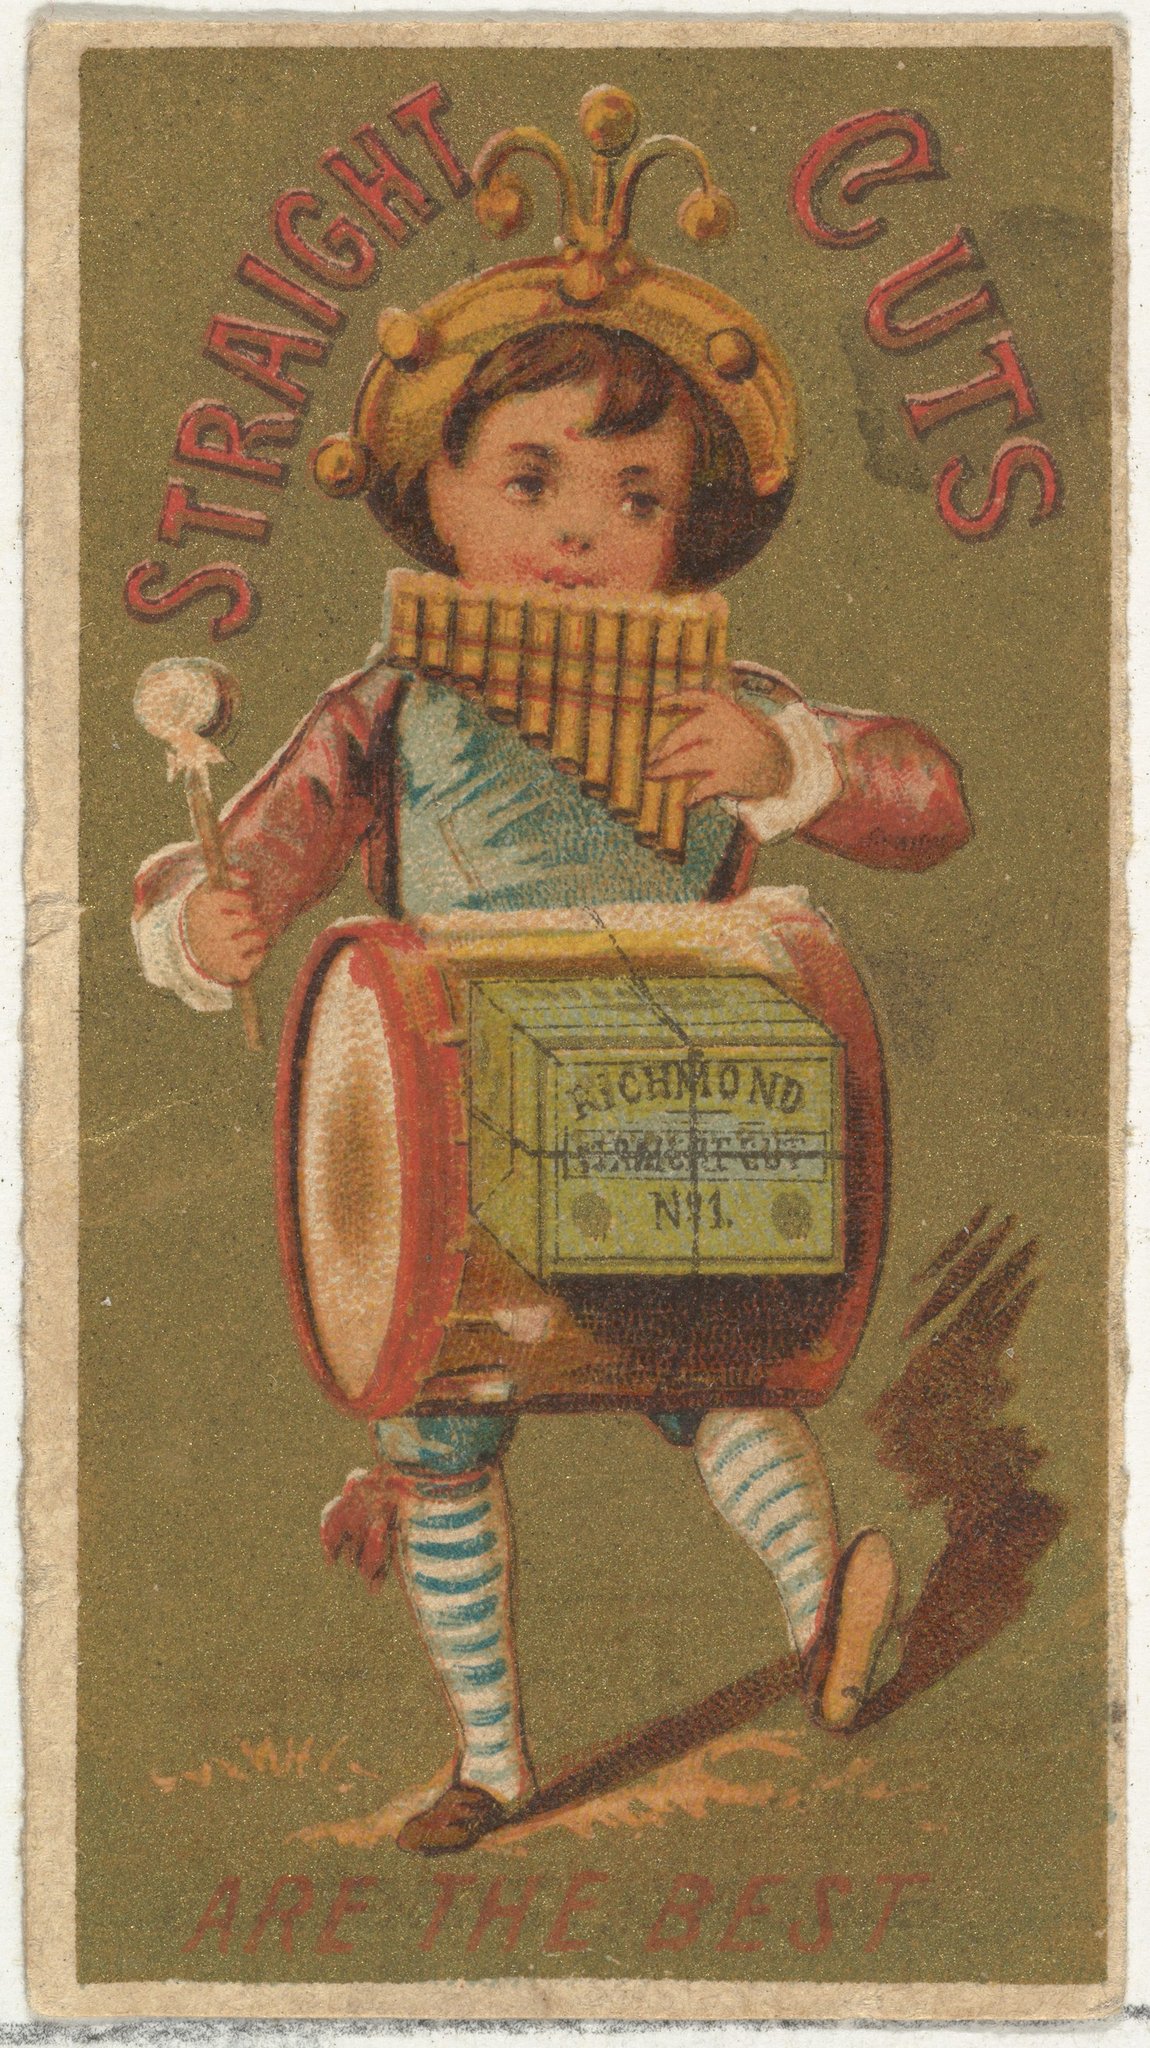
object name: print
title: From the Girls and Children series (N65) promoting Richmond Straight Cut Cigarettes for Allen & Ginter brand tobacco products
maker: allen & ginter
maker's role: publisher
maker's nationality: american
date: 1886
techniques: color lithograph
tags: girls,drums